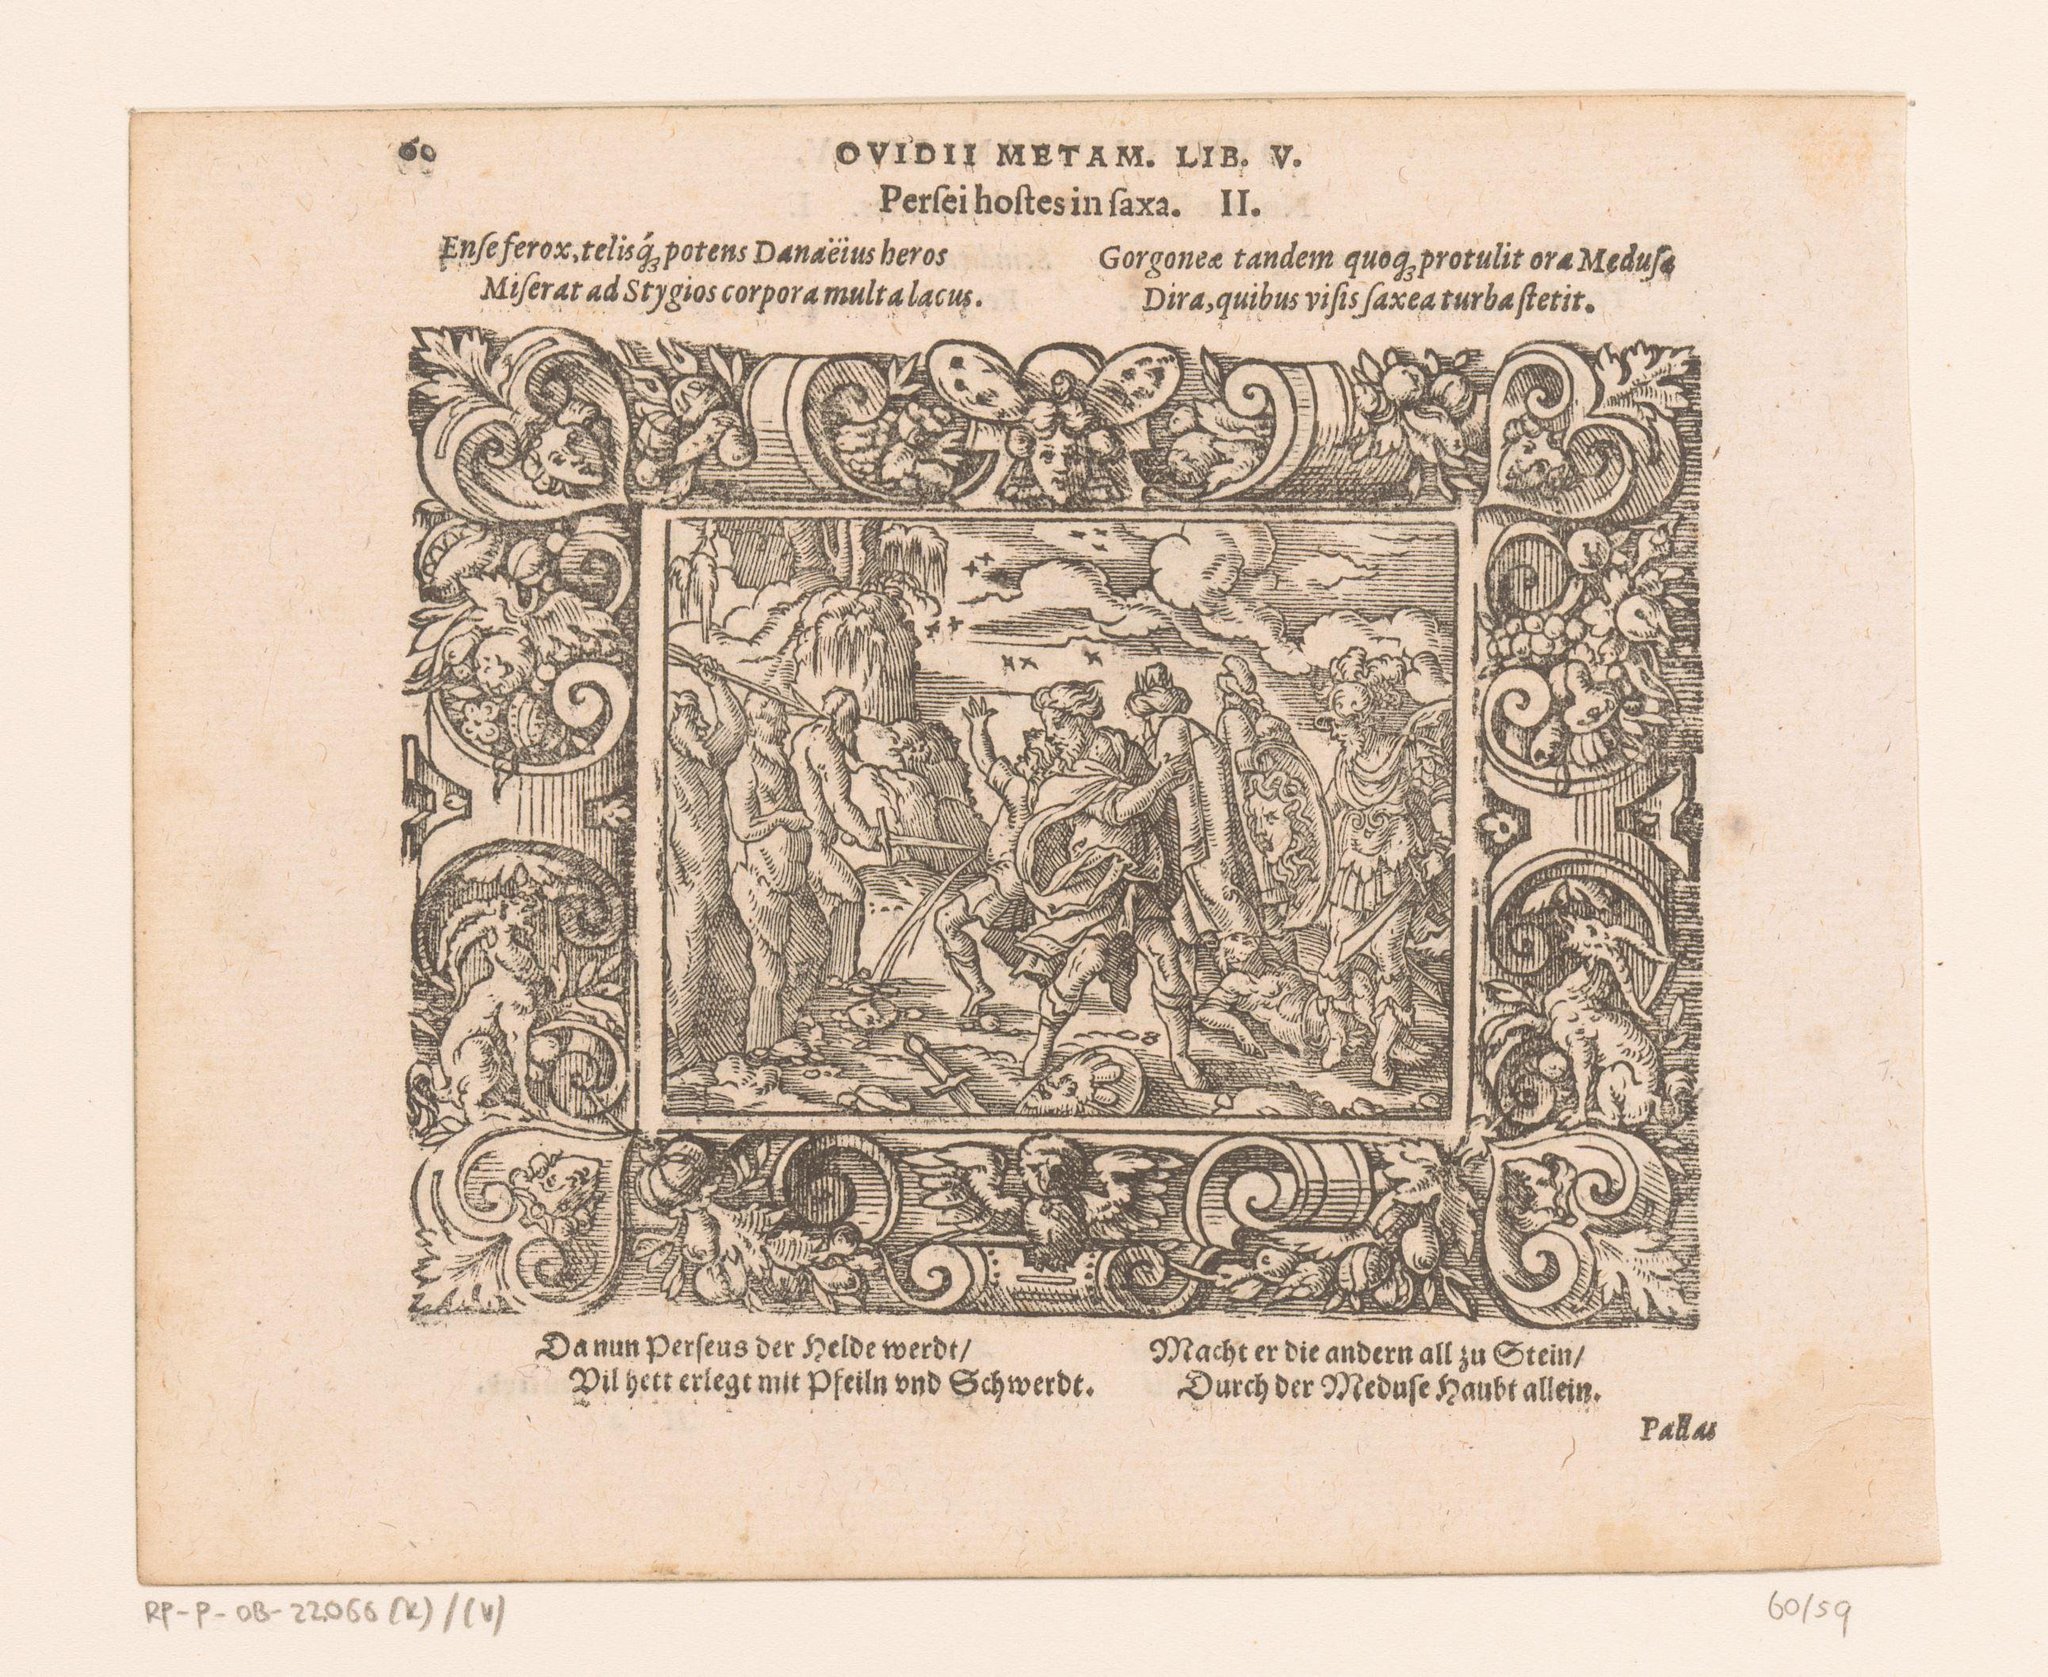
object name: book illustration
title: Phineus en zijn volgelingen in steen veranderd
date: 1569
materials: paper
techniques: letterpress printing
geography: frankfurt am main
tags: scrollwork, strapwork ~ ornament, phineus and his attendants are turned into stone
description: Illustratie bij de Metamorfosen van Ovidius, afkomstig uit de publicatie: Posthius, Johannes. Tetrasticha in Ovidii metam. Frankfurt am Main: Georg Rab en Sigmund Feyerabend en erven Weigand Han, 1569. De voorstellingen en ornamentranden van deze boekillustraties zijn van twee aparte blokken gedrukt. Beide werden afzonderlijk van elkaar ook gebruikt voor andere publicaties, en de ornamentranden werden eveneens binnen deze publicatie meerdere keren gebruikt.